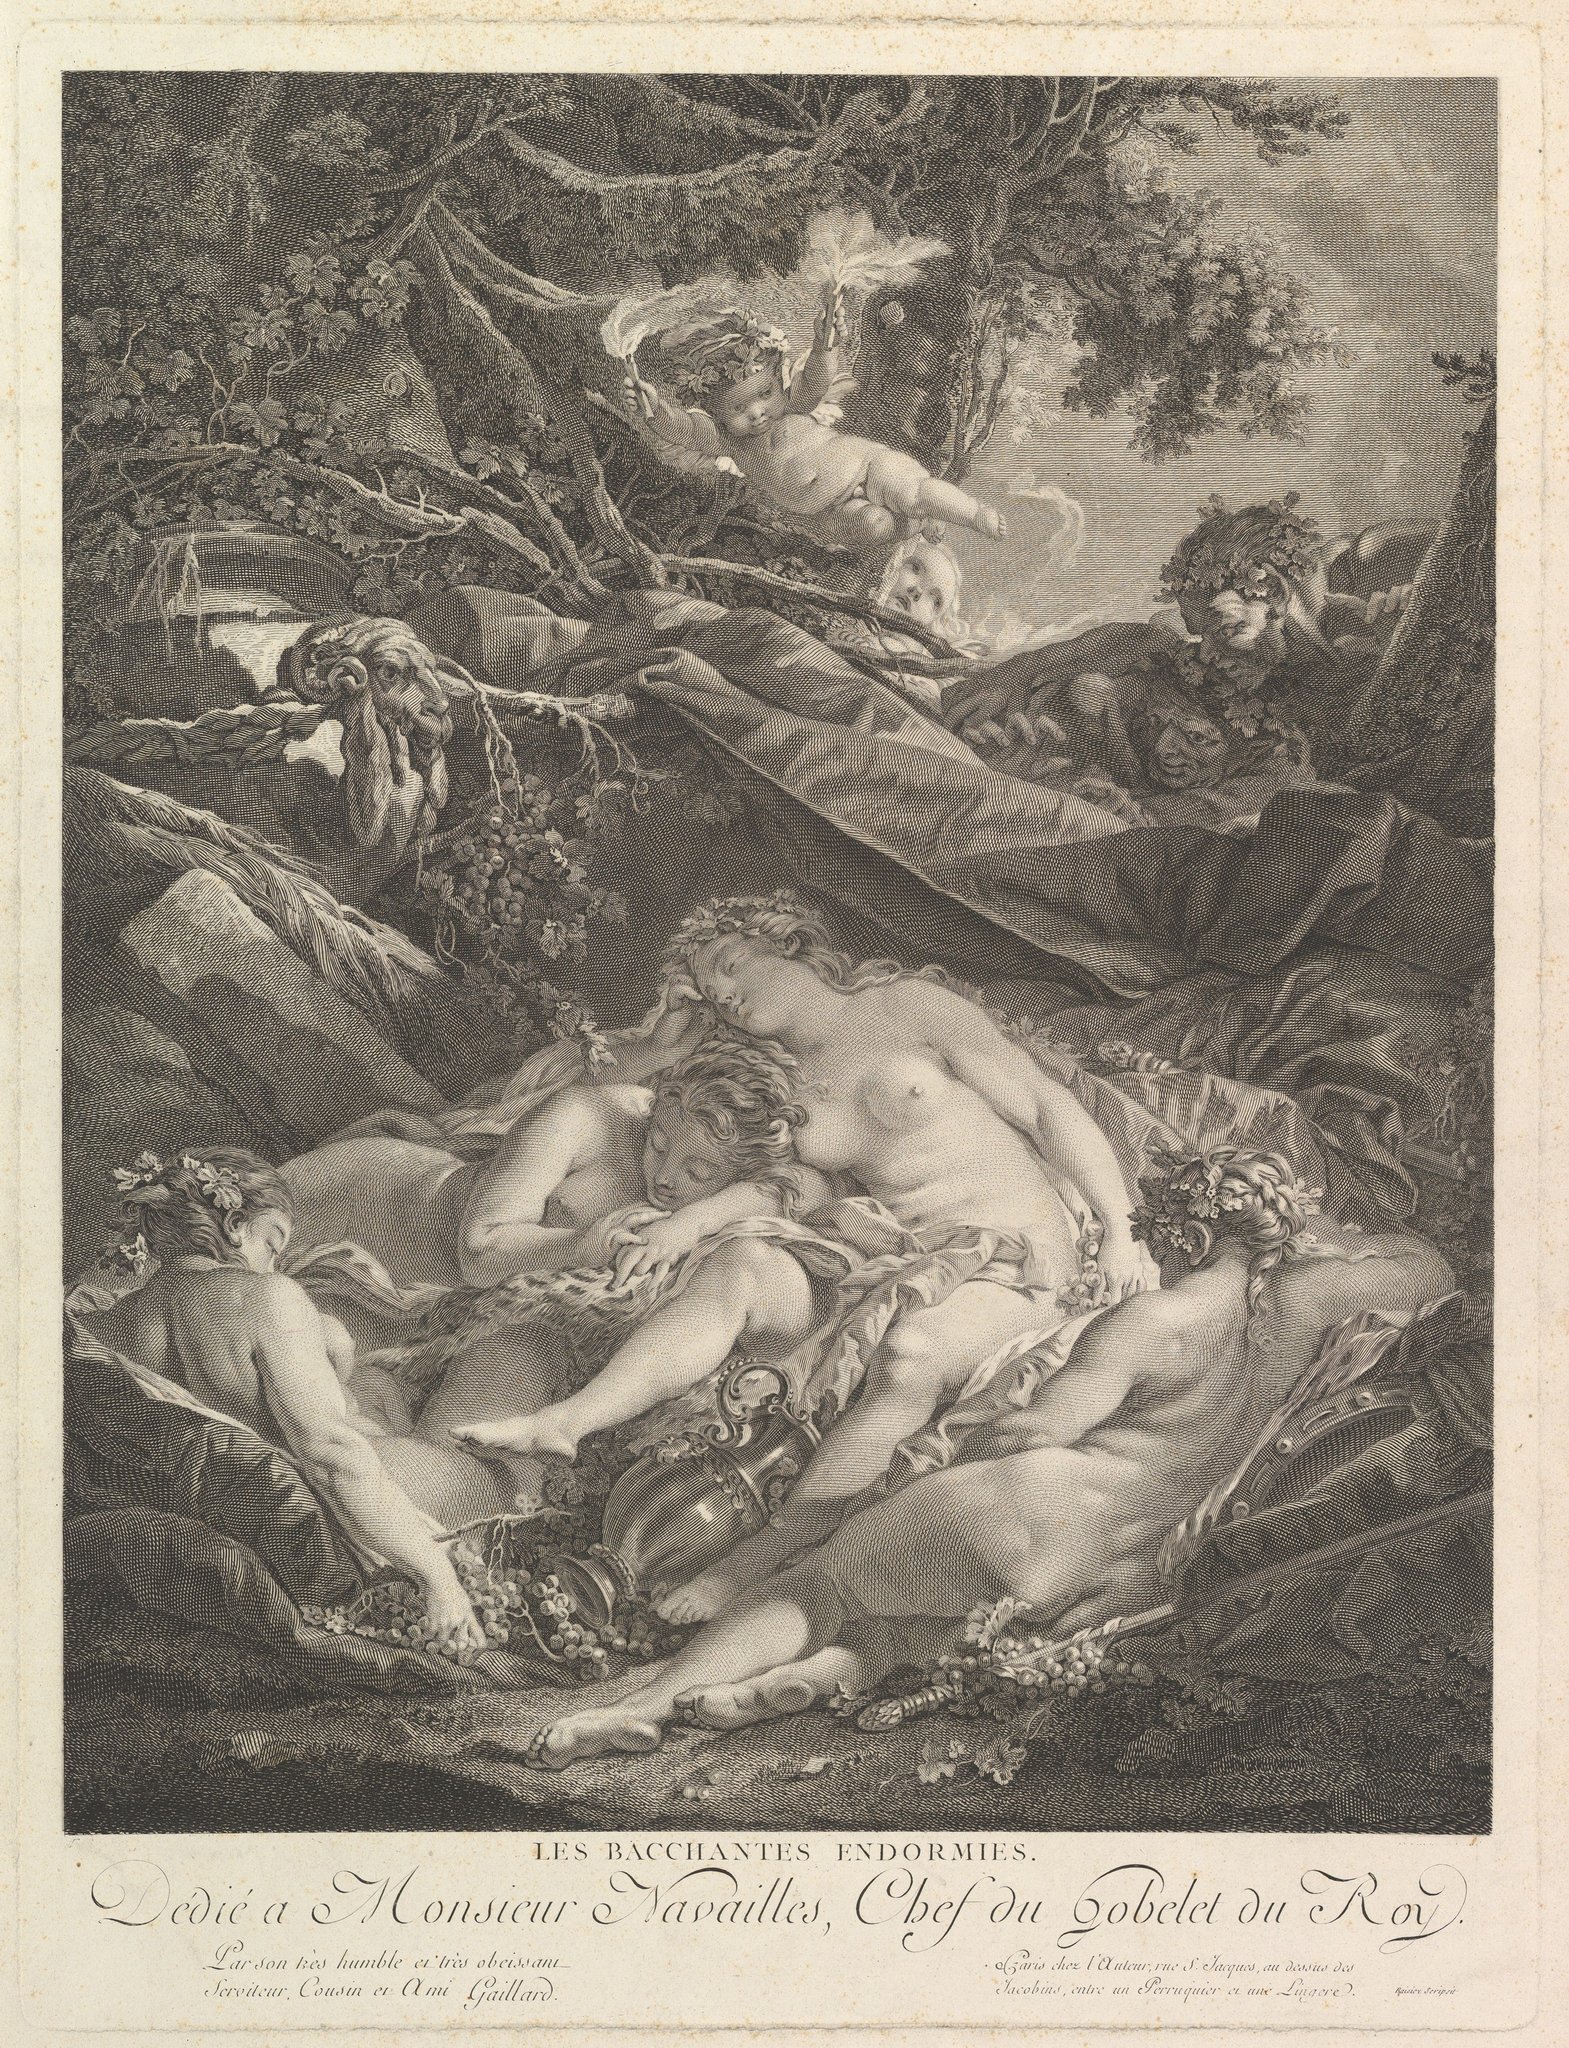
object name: print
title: Les Bacchantes Endormies (The Sleeping Bacchantes)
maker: rené gaillard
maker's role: artist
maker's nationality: french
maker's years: 1714-1790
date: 1764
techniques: engraving, etching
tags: sleeping,bacchantes